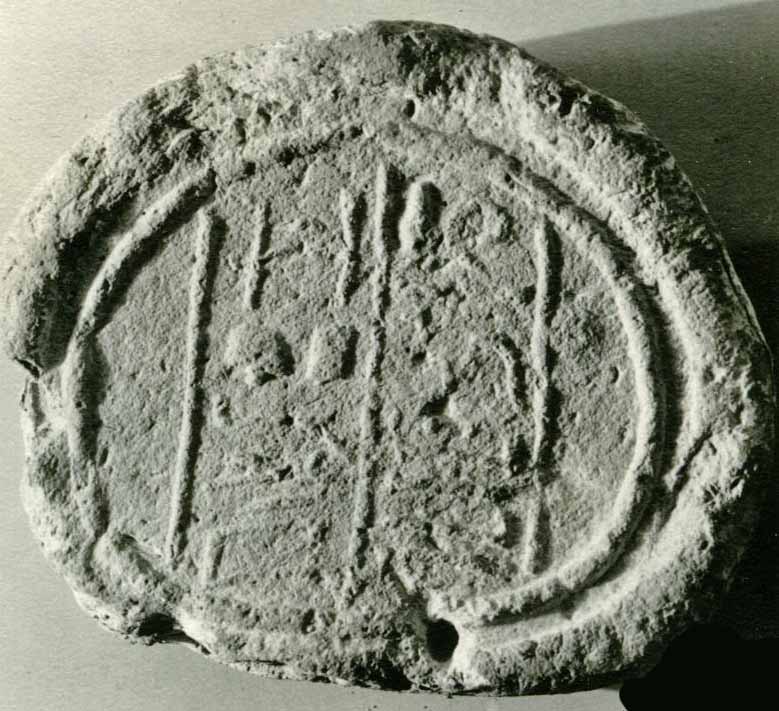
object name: cone, amunedjeh, circular impression, herald, law court, overseer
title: Funerary Cone of the First King's Herald Amunedjeh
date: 1479-1400 BCE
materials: pottery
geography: egypt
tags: hieroglyphs